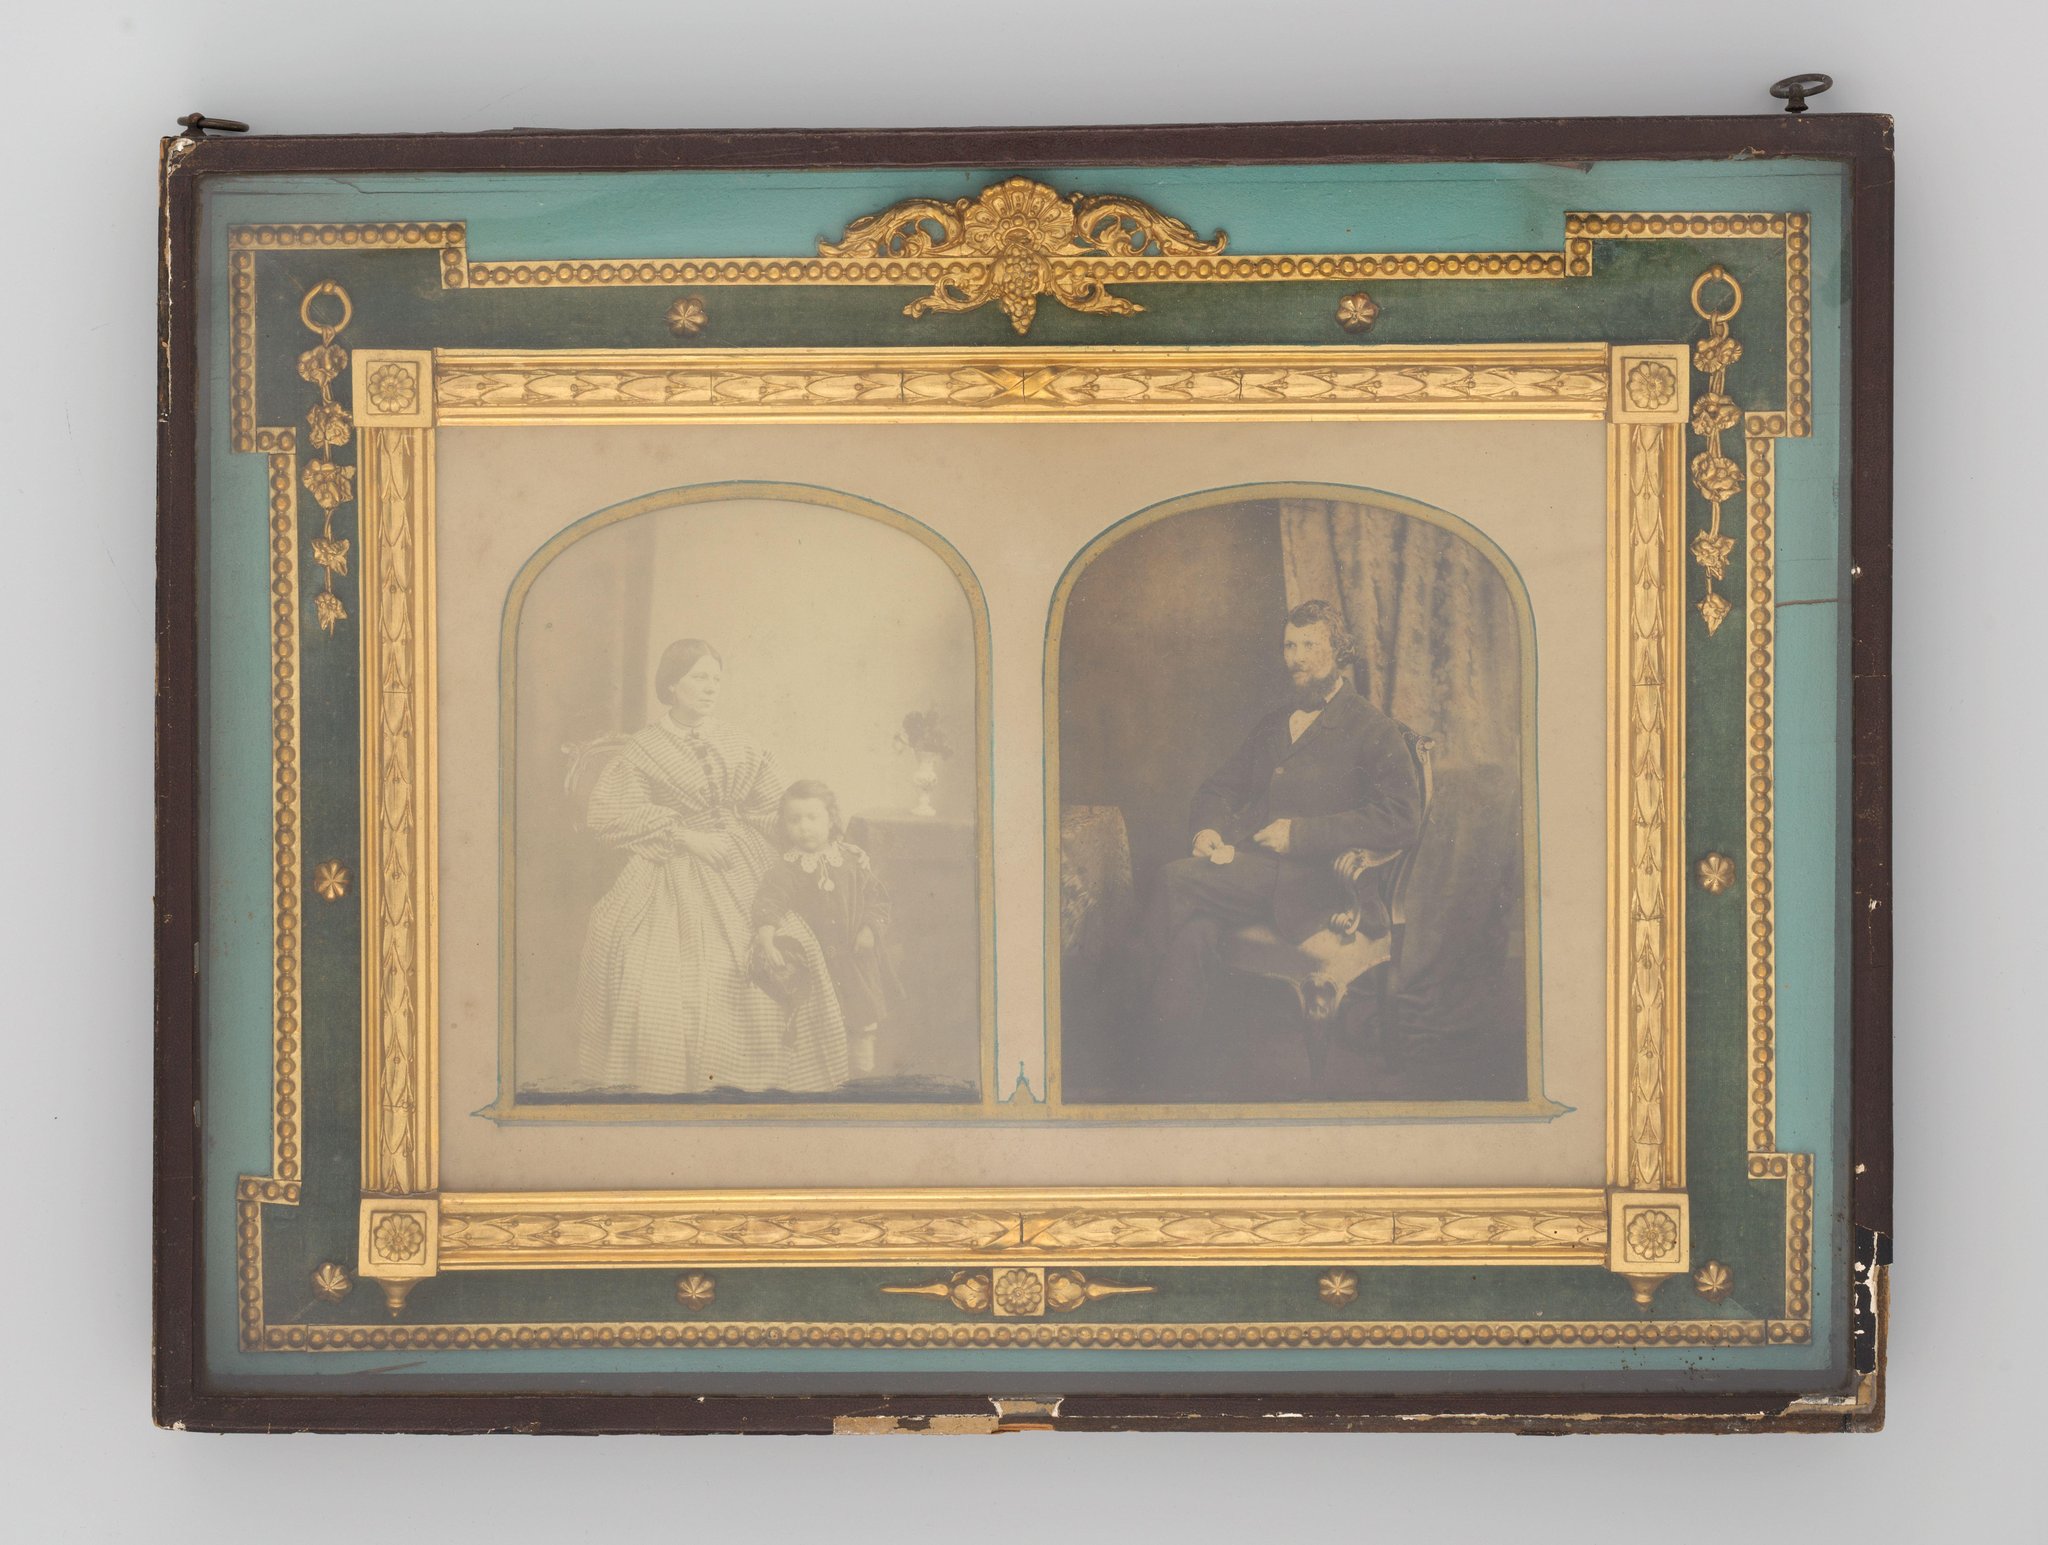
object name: photograph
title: Portret van een onbekende zittende vrouw met kind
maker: Anonymous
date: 1851-1900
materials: cardboard, paper, velvet, wood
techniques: albumen print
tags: sitting figure - aa - female human figure, mother and baby or young child, anonymous historical person portrayed - bb - woman